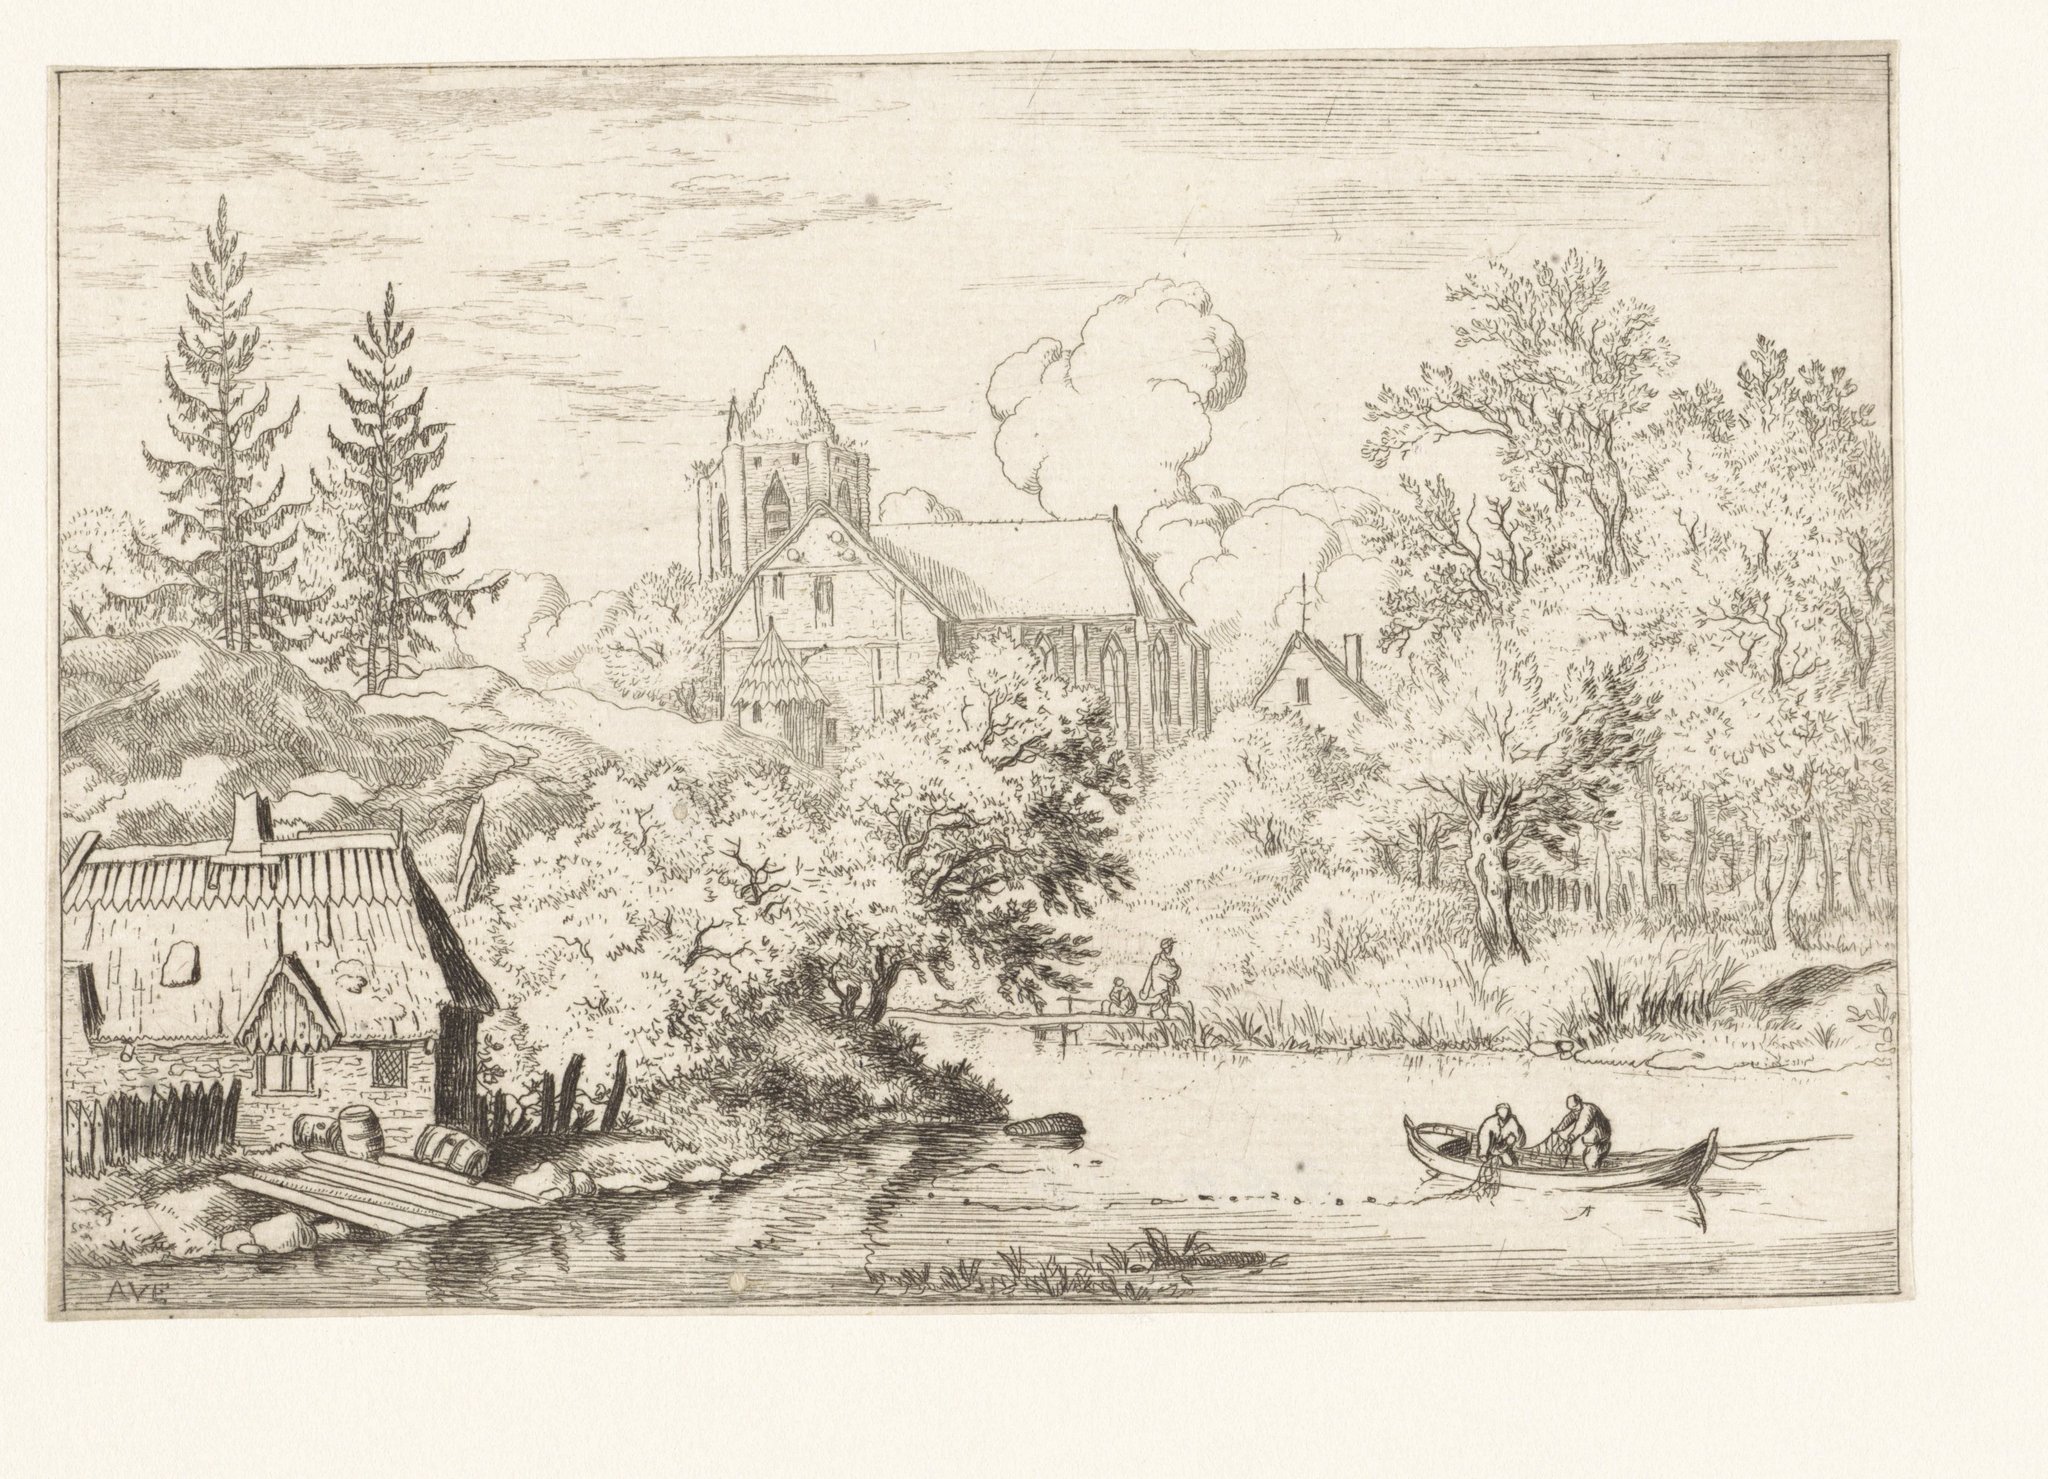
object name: print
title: Vaten en planken aan de oever van de rivier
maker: allaert van everdingen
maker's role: draughtsman, painter, print maker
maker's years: 1621-1675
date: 1631-1675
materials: paper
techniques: etching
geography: netherlands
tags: sports, games ~ animals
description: Rivierlandschap met uitzicht op een kerk. In een roeiboot halen twee personen een visnet binnen. Op de oever van de rivier, bij een huis, liggen enkele planken en vaten.